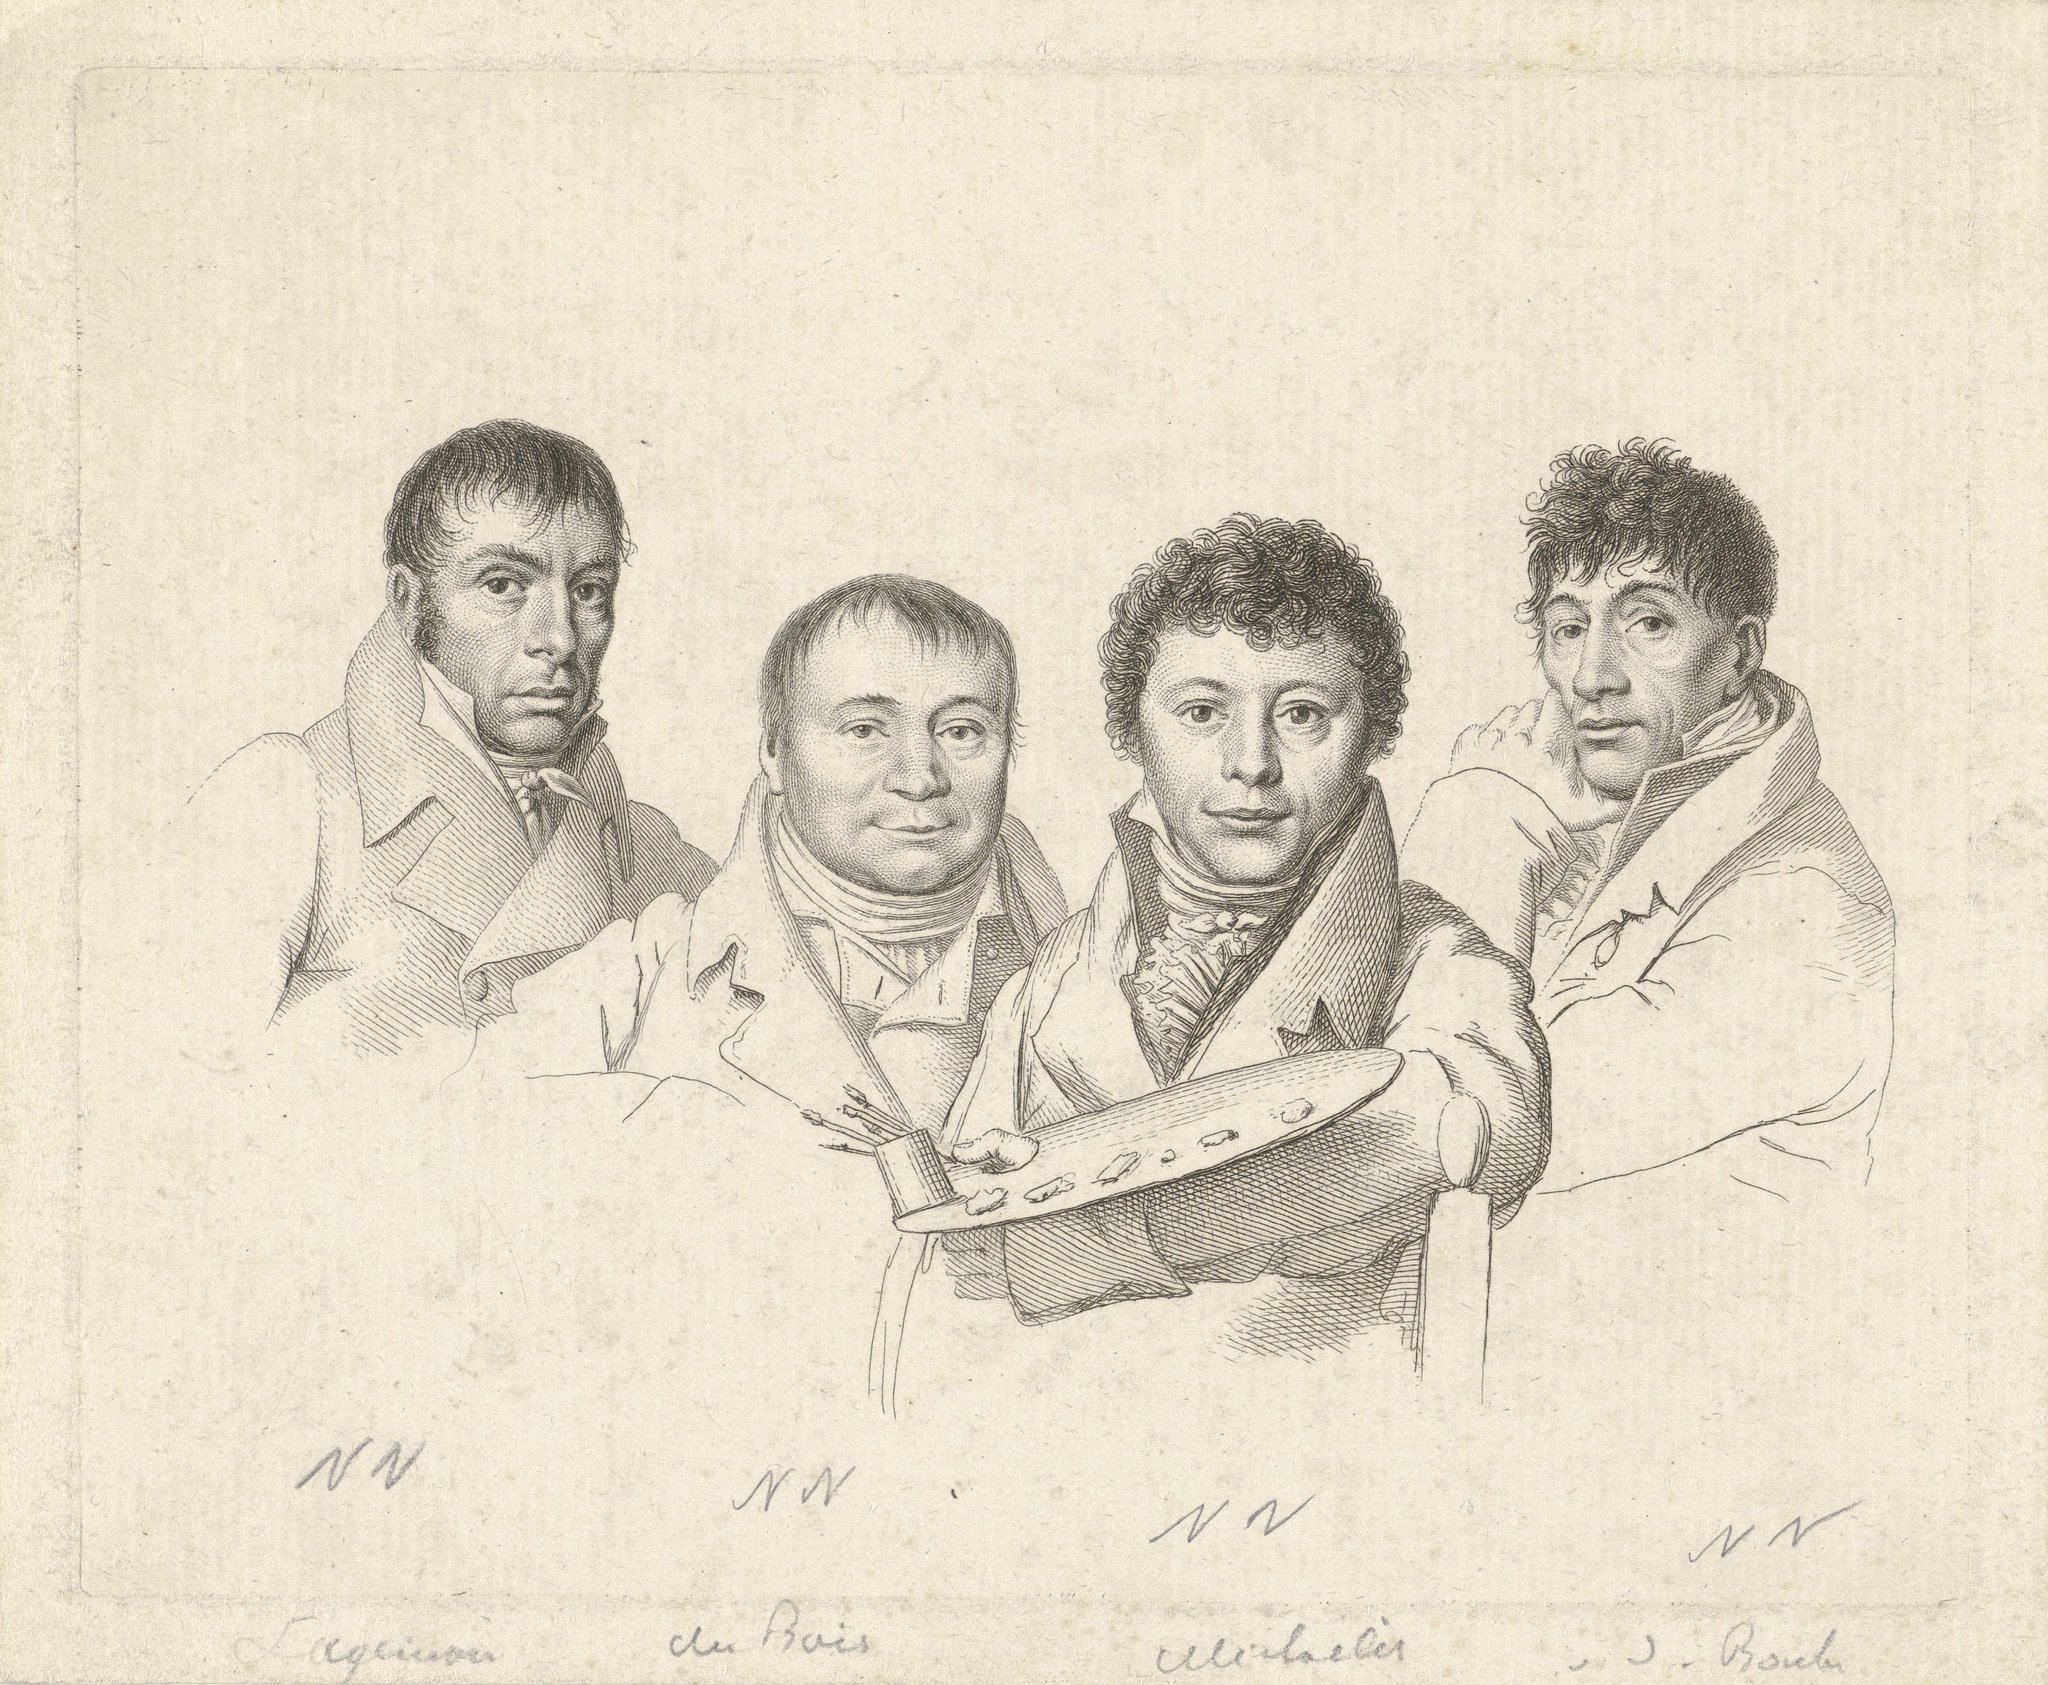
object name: print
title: Portretten van H. Lageman, Ch. Dubois, G.J. Michaëlis en A. van den Bos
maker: jacob ernst marcus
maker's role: draughtsman, print maker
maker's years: 1774-1826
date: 1811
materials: paper, pencil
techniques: etching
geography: amsterdam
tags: nijmegen, amsterdam, print maker, draughtsman, anthonie van den bos, chrétien dubois, painter, gerrit jan michaëlis, hendrik lageman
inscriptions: name: ‘Lageman du Bois Michaelis v Bosch’, collector's mark: Lugt 2228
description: Portretten van de kunstenaars Hendrik Lageman, Chrétien Dubois, Gerrit Jan Michaëlis en Anthonie van den Bos.